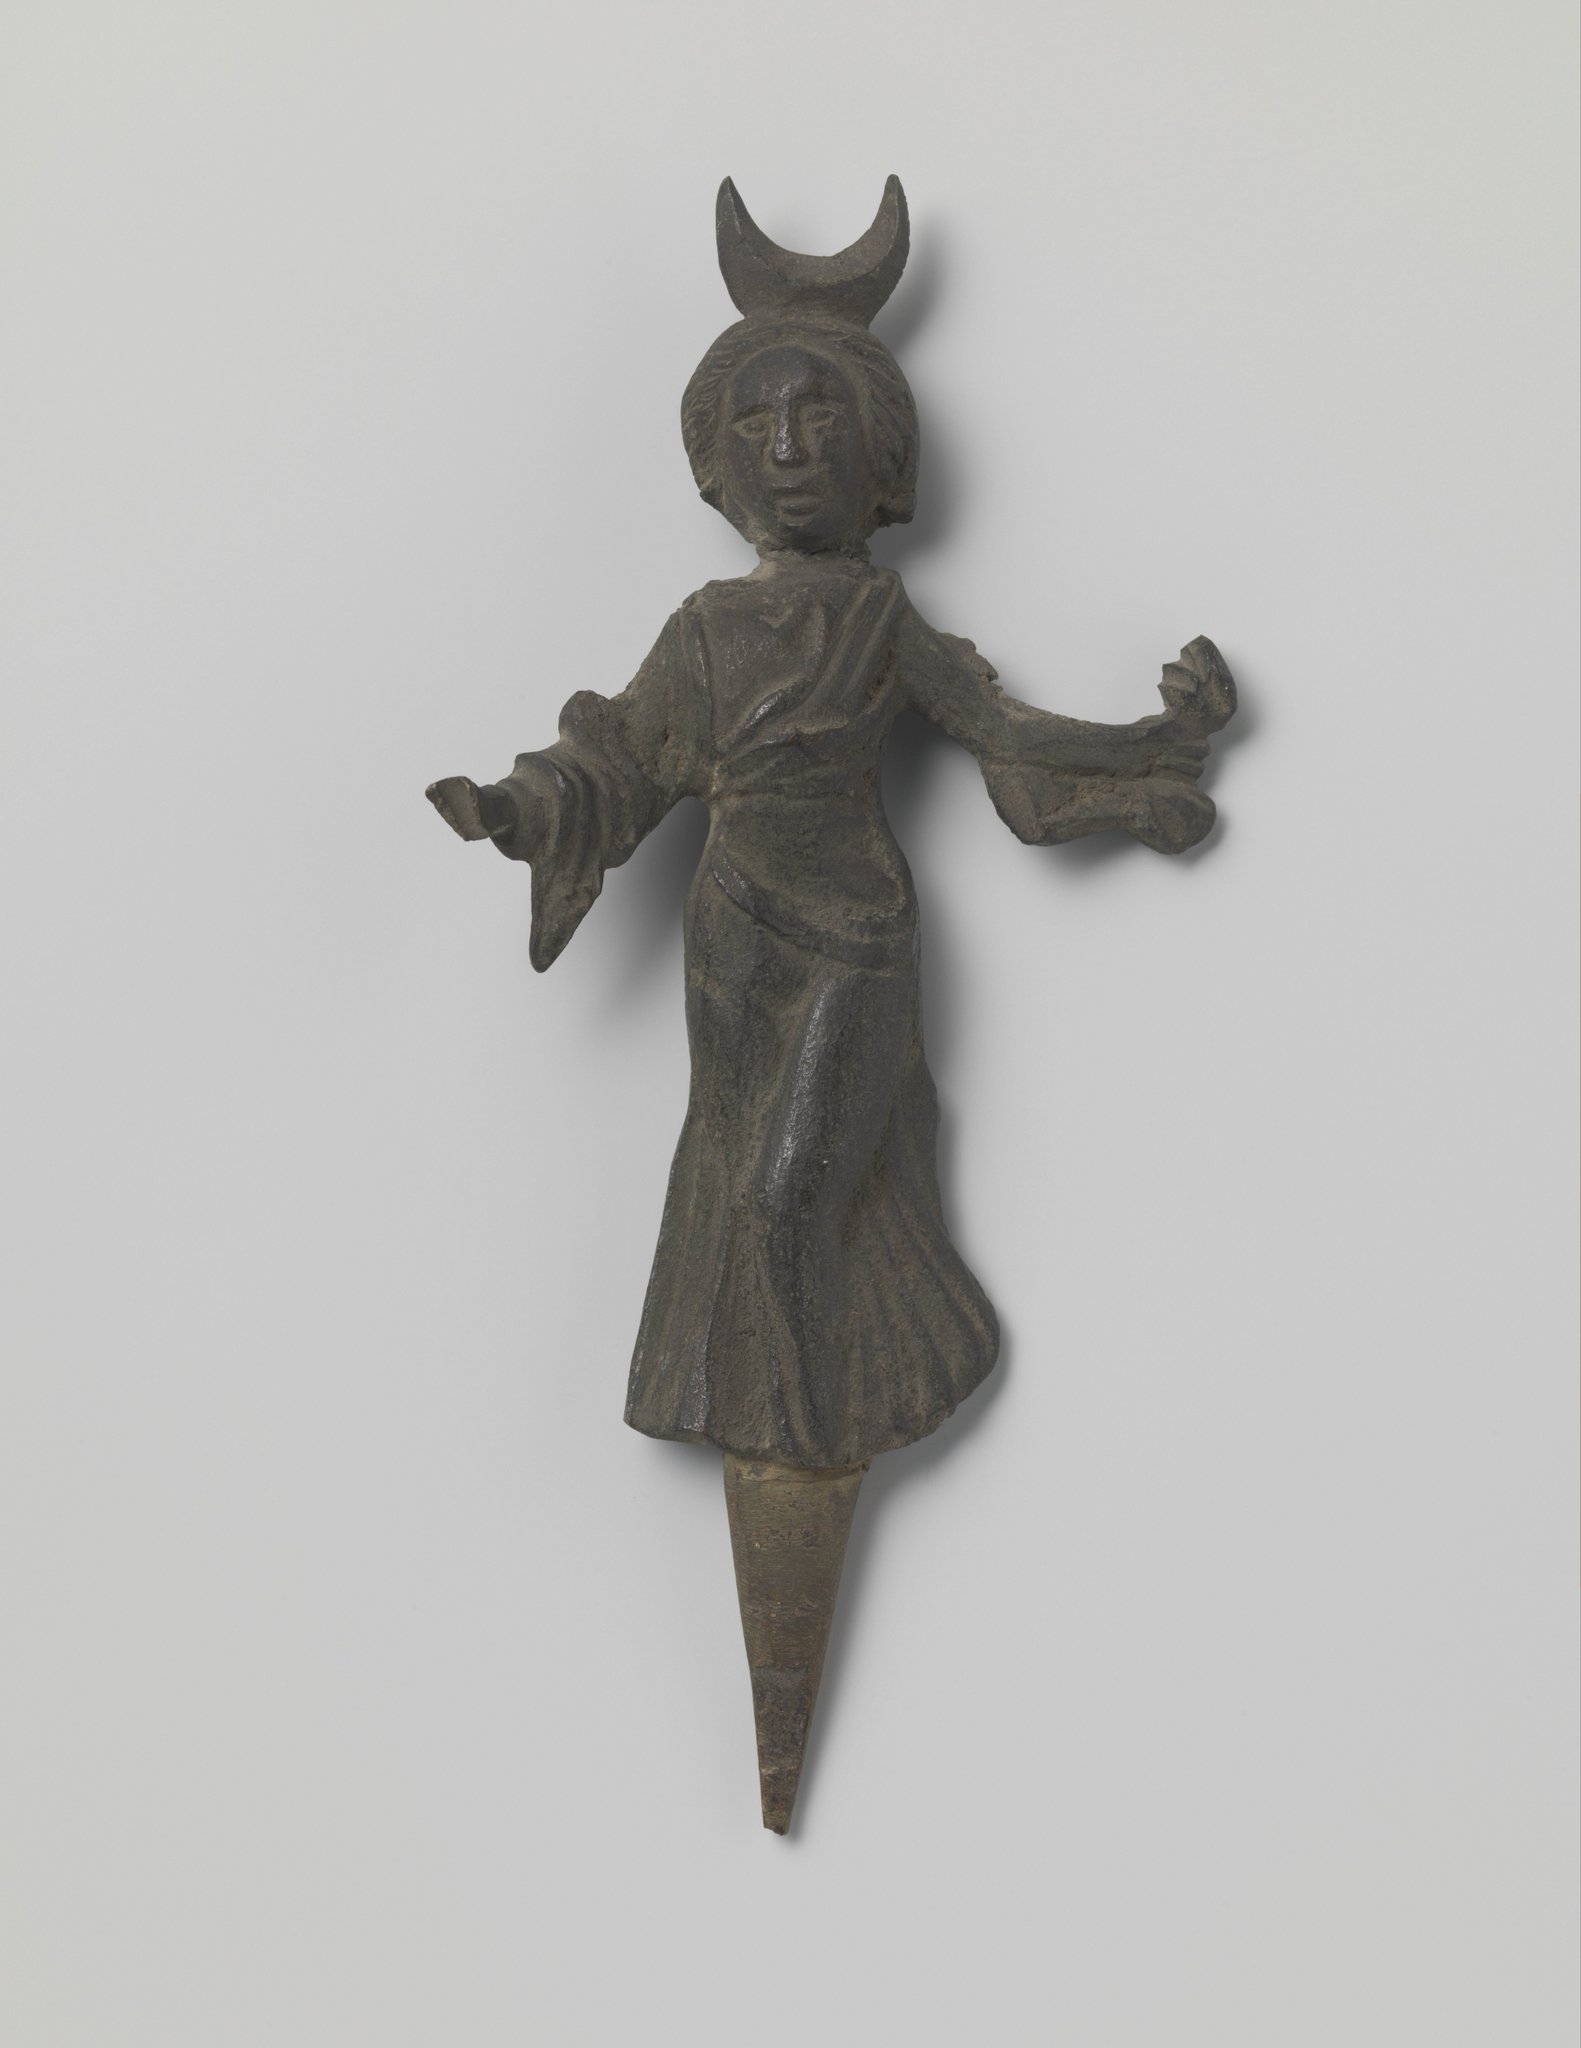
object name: figure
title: Maangodin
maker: Anonymous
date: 1700-1800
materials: brass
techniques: casting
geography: netherlands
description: De als één geheel gegoten staande vrouwenfiguur heeft in haar linkerhand een draperie. Haar rechterhand is afgebroken. Op het hoofd een maan. Met een pin kan het voorwerp, waarvan de functie onbekend is, ergens ingestoken worden.